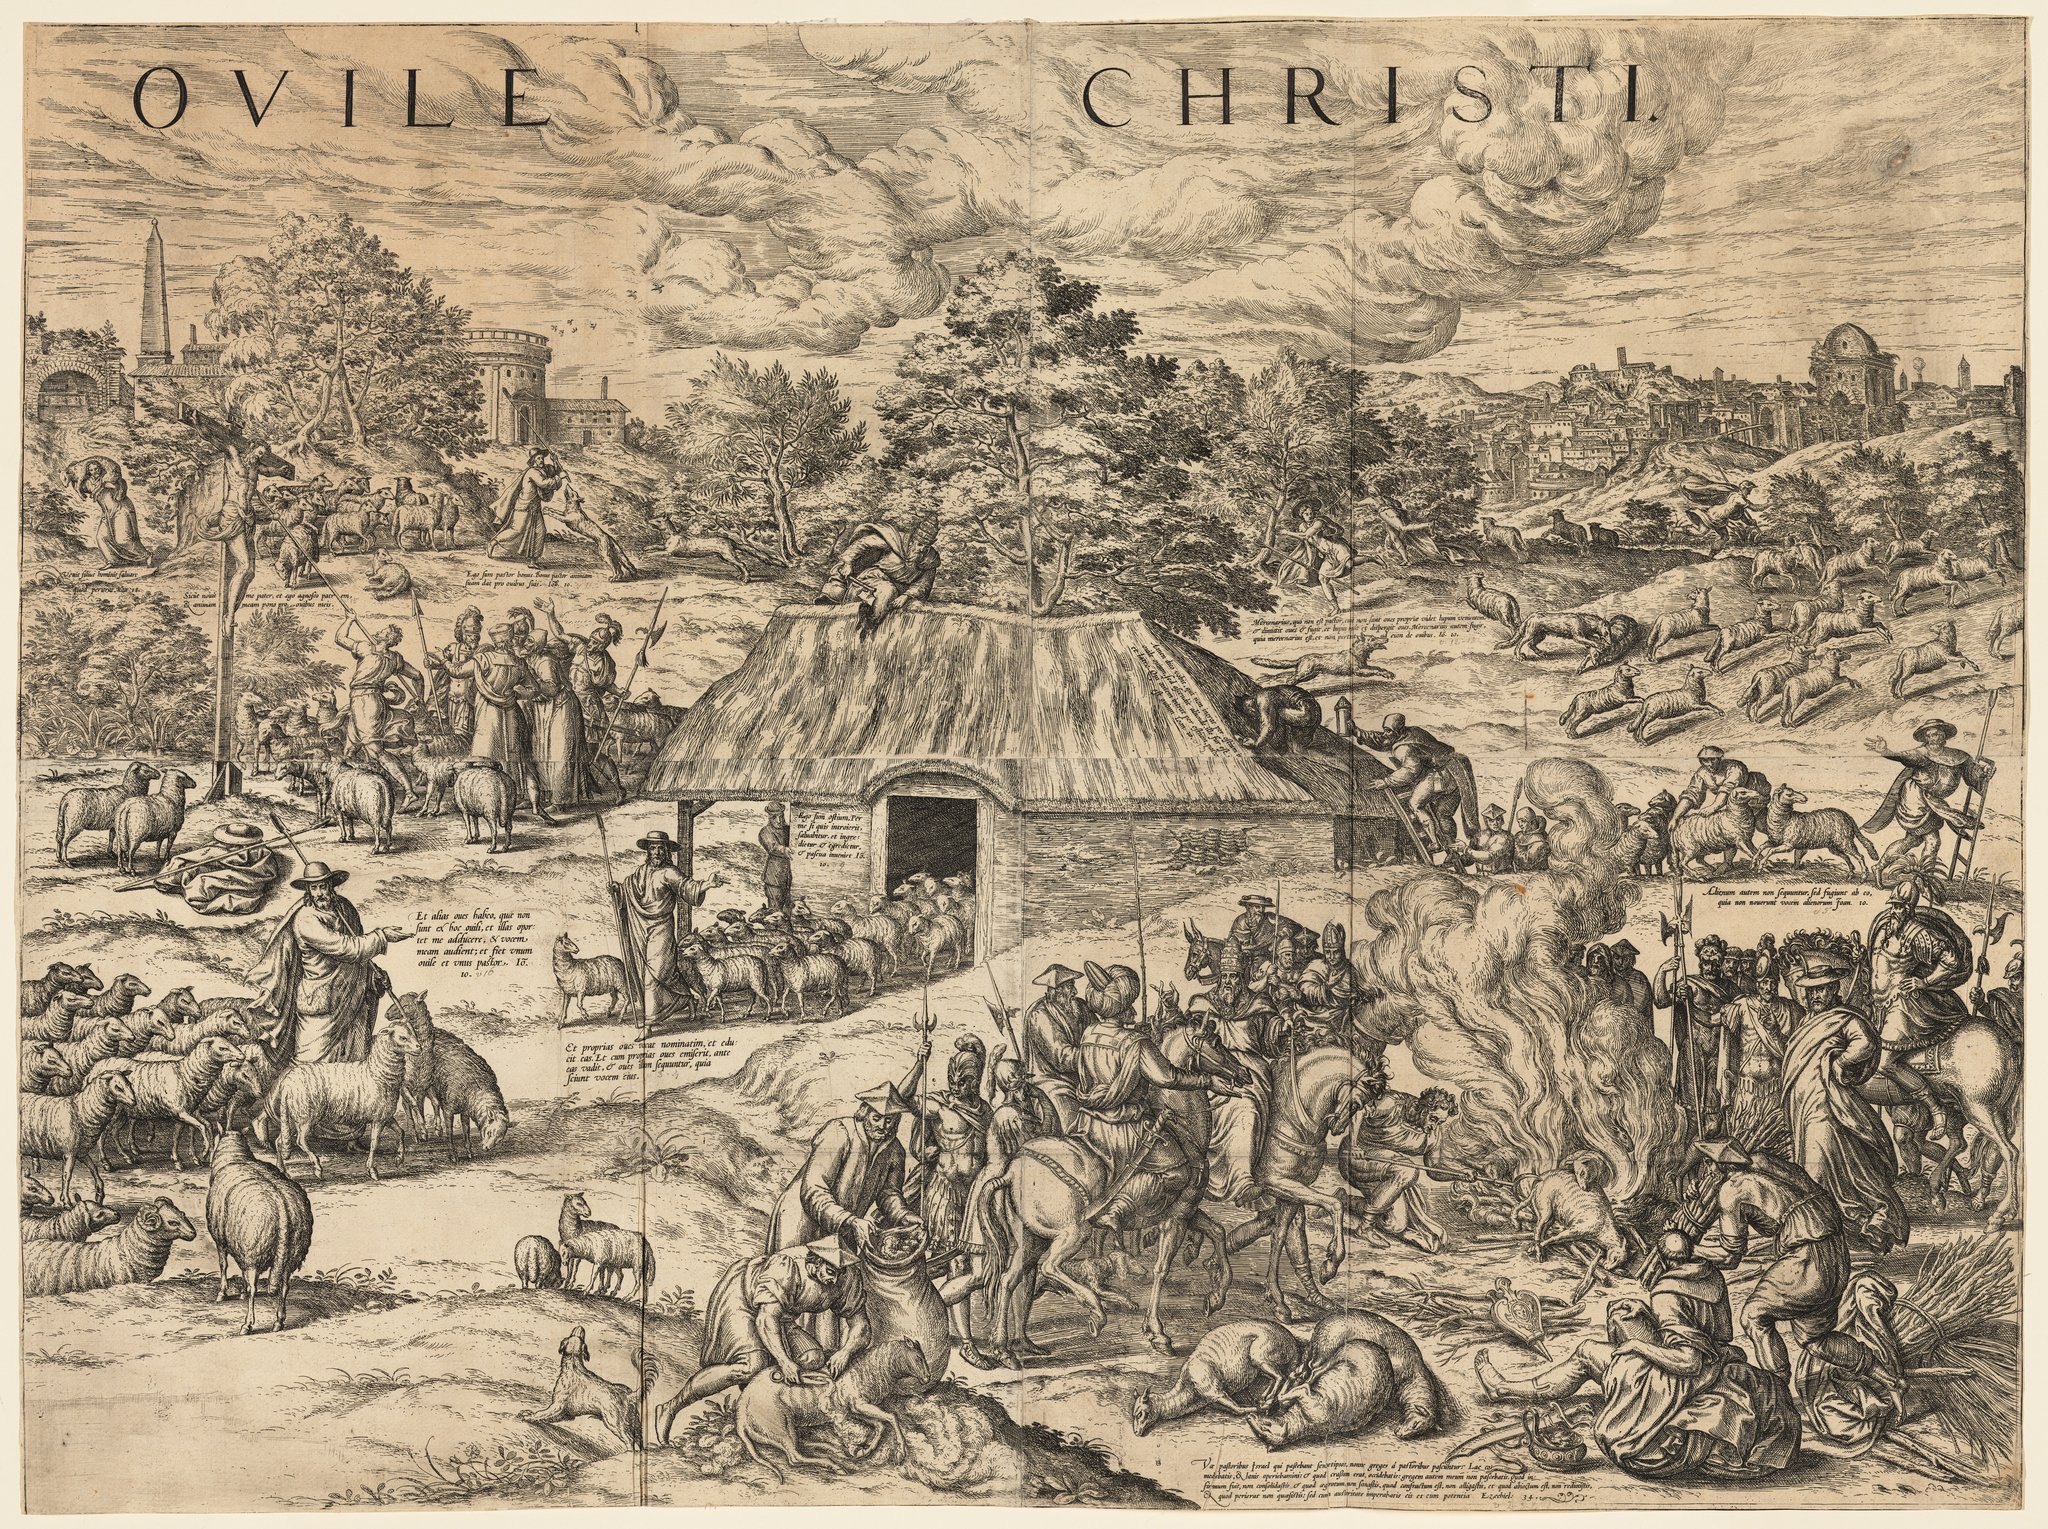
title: The Parable of the Good Shepherd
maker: anonymous, netherlandish, late 16th century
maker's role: artist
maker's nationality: netherlandish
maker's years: 1550-1600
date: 1570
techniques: etching, printing